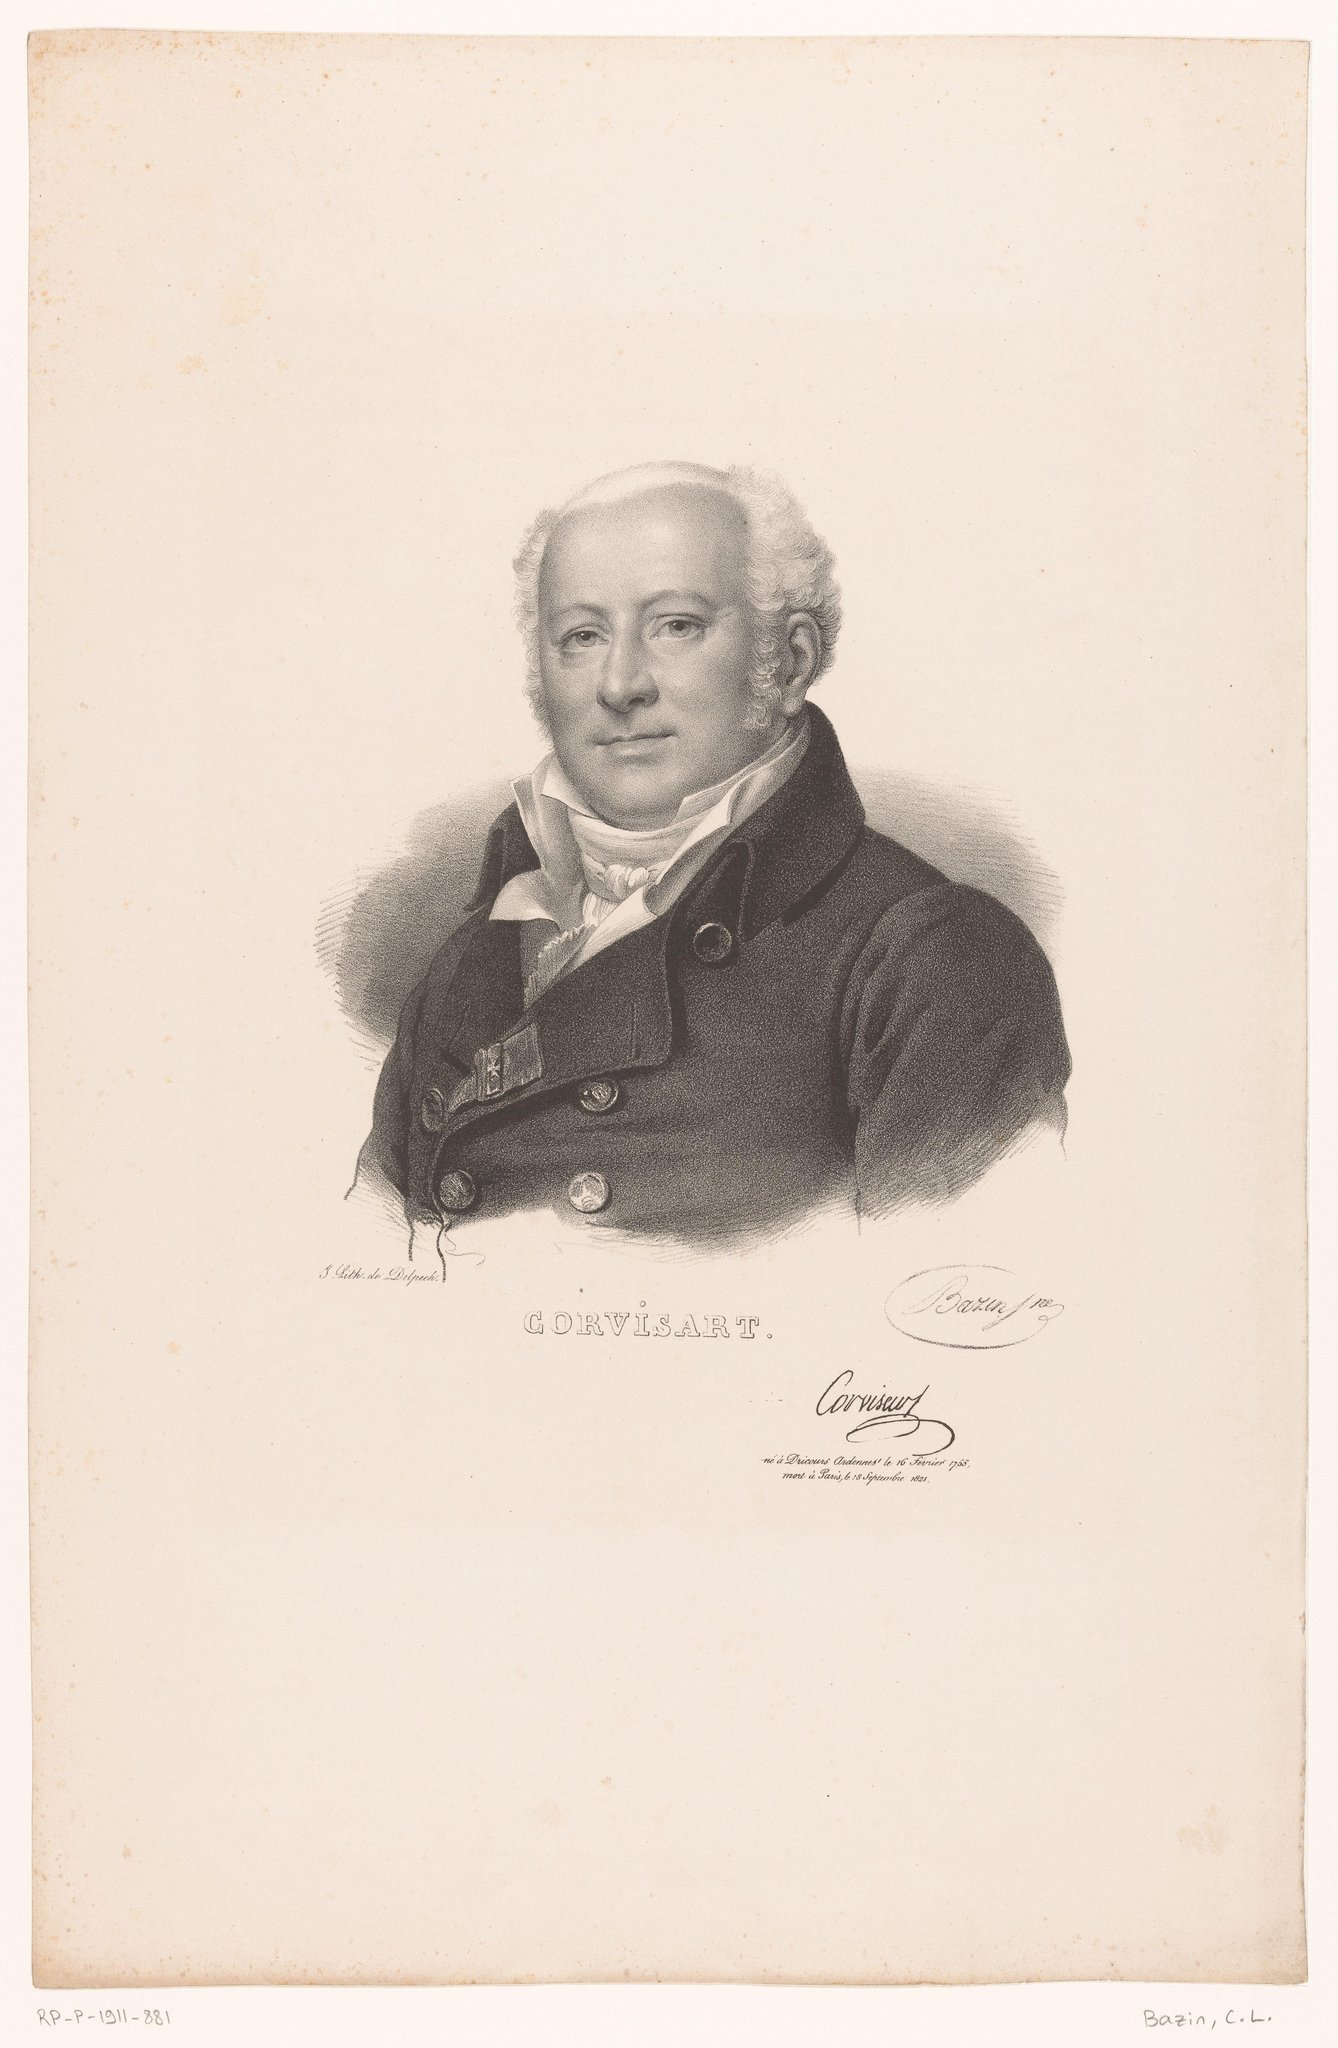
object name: print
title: Iconographie des contemporains depuis 1789 jusqu'à 1820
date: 1832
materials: paper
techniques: lithograph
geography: paris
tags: historical persons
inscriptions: collector's mark: Lugt 2228a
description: De serie Iconographie des contemporains depuis 1789 jusqu'à 1820 is uitgegeven tussen 1822 en 1833 in verschillende livraisons.